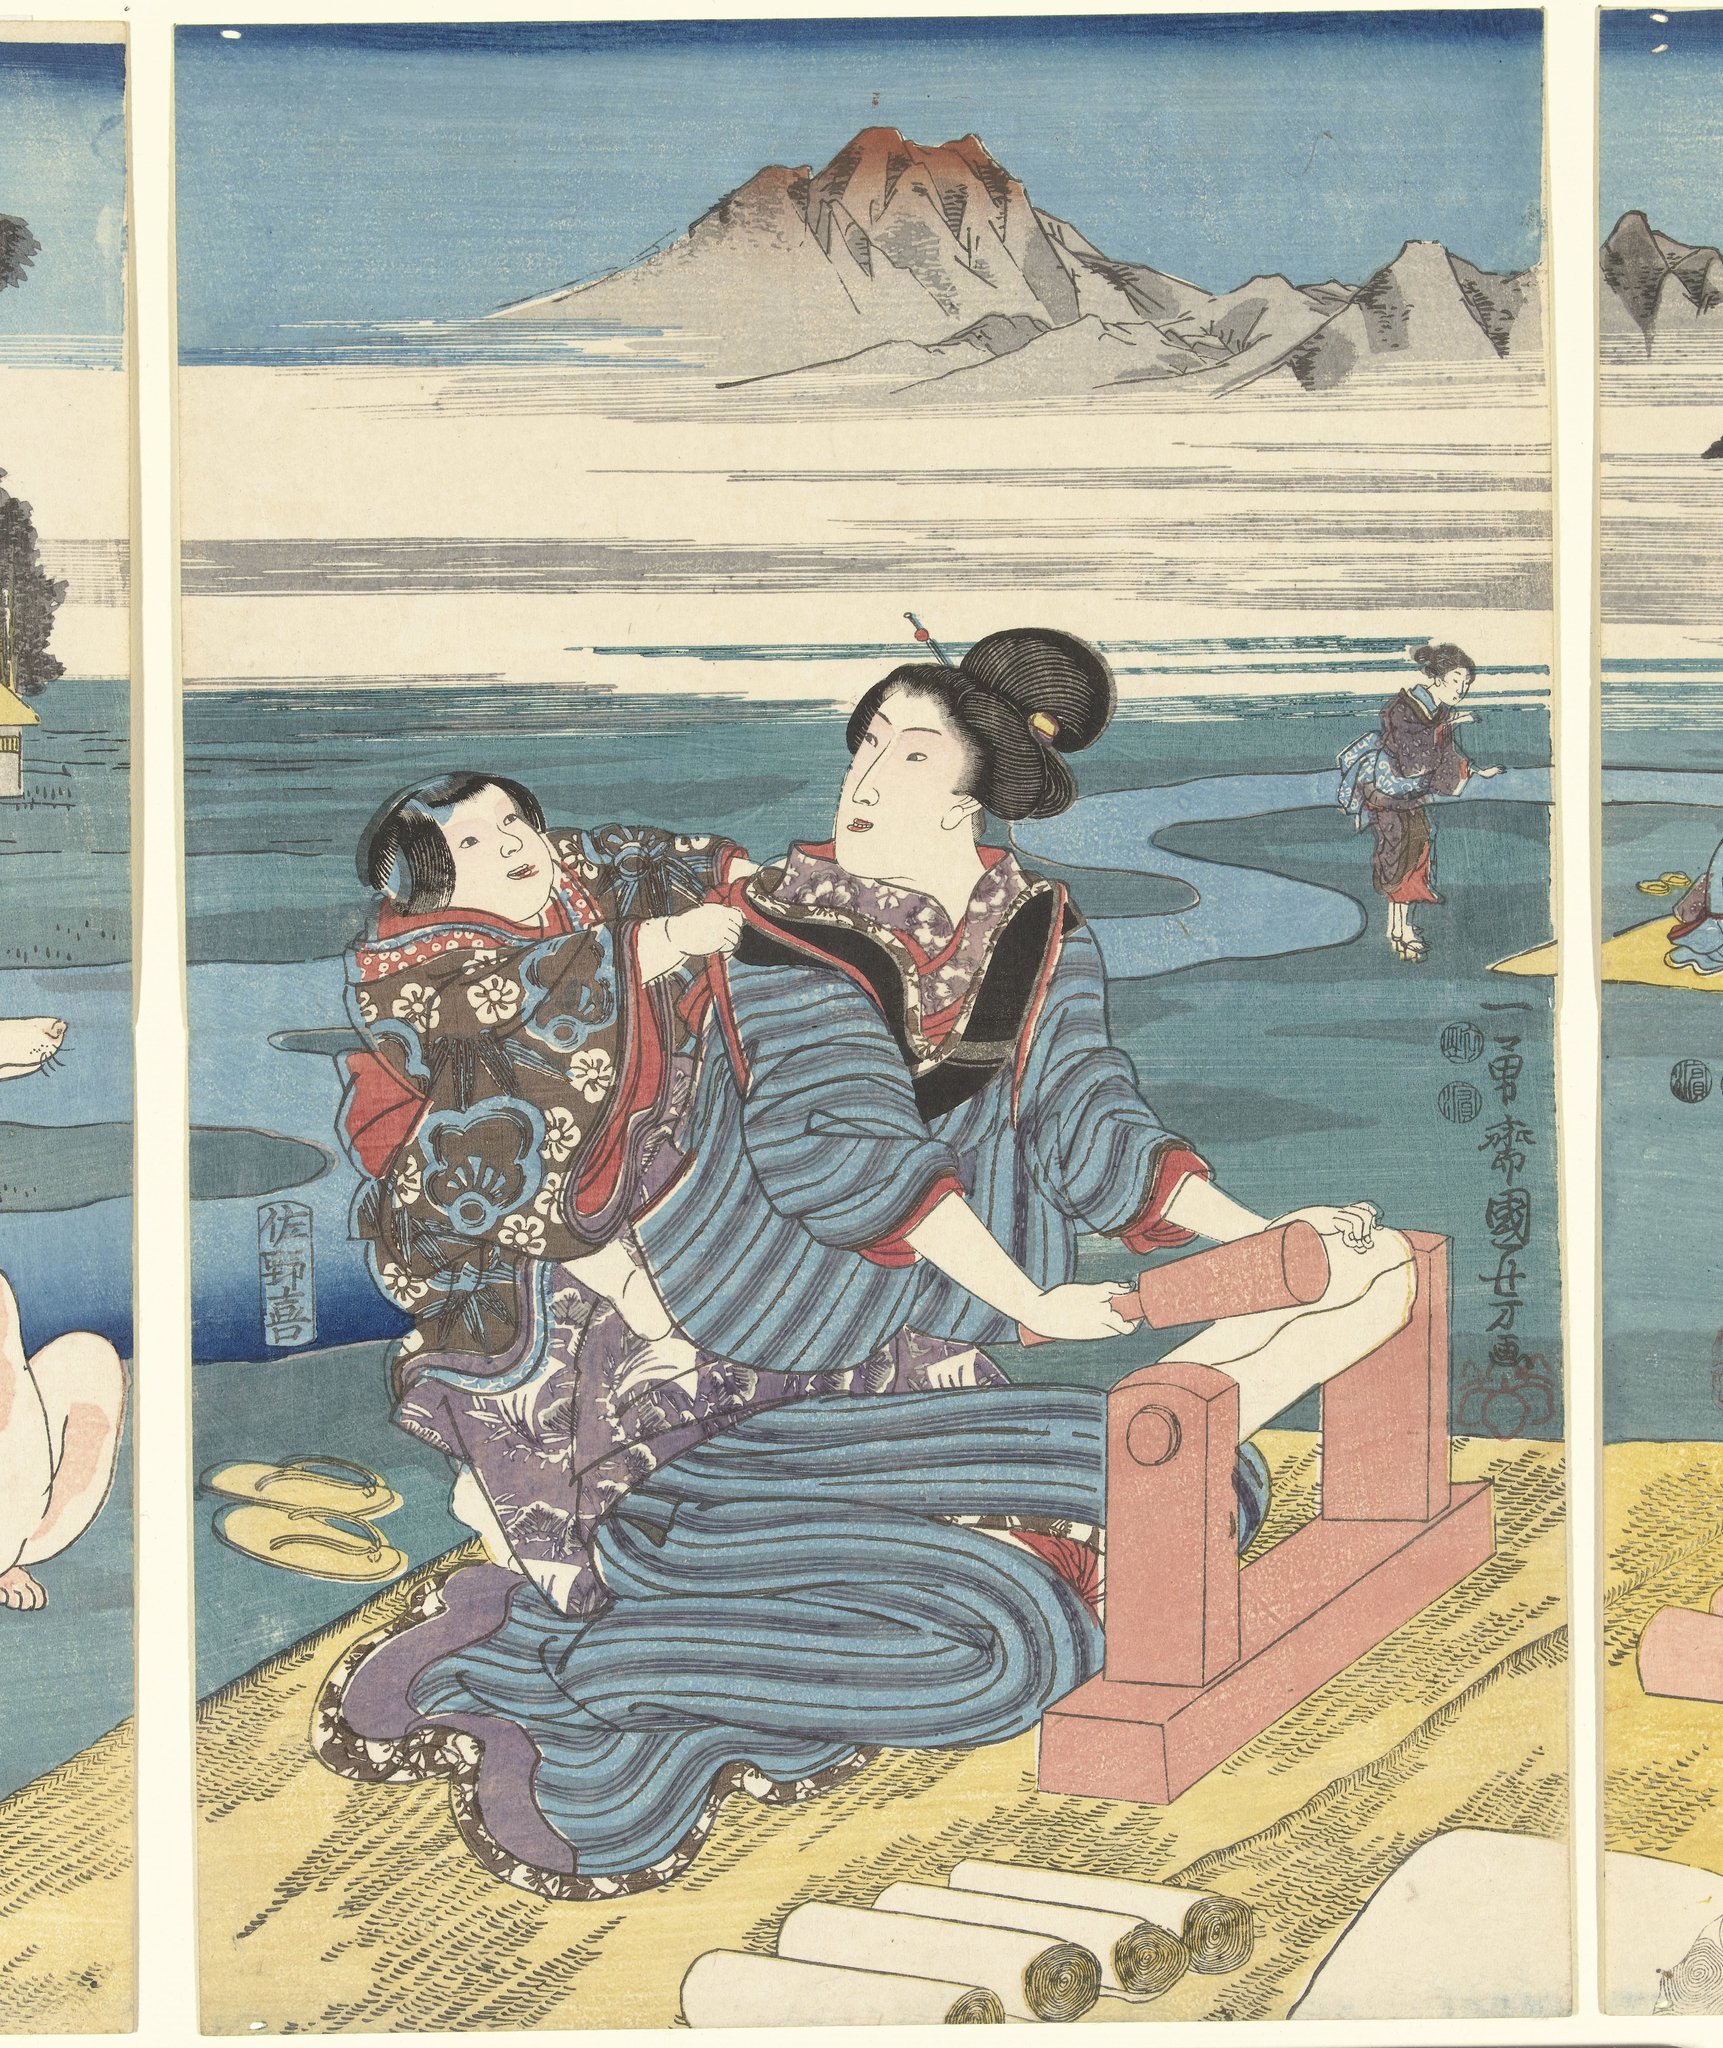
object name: print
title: De Toi Tama rivier in de provincie Settsu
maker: utagawa kuniyoshi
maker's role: draughtsman, print maker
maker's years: 1798-1861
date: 1847-1848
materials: paper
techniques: woodcut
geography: japan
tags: fulling ~ cloth finishing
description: Vrouw met kind op de rug, laken vollend op gele mat bij rivier; op de achtergrond een tweede vrouw en mist waarachter bergen.